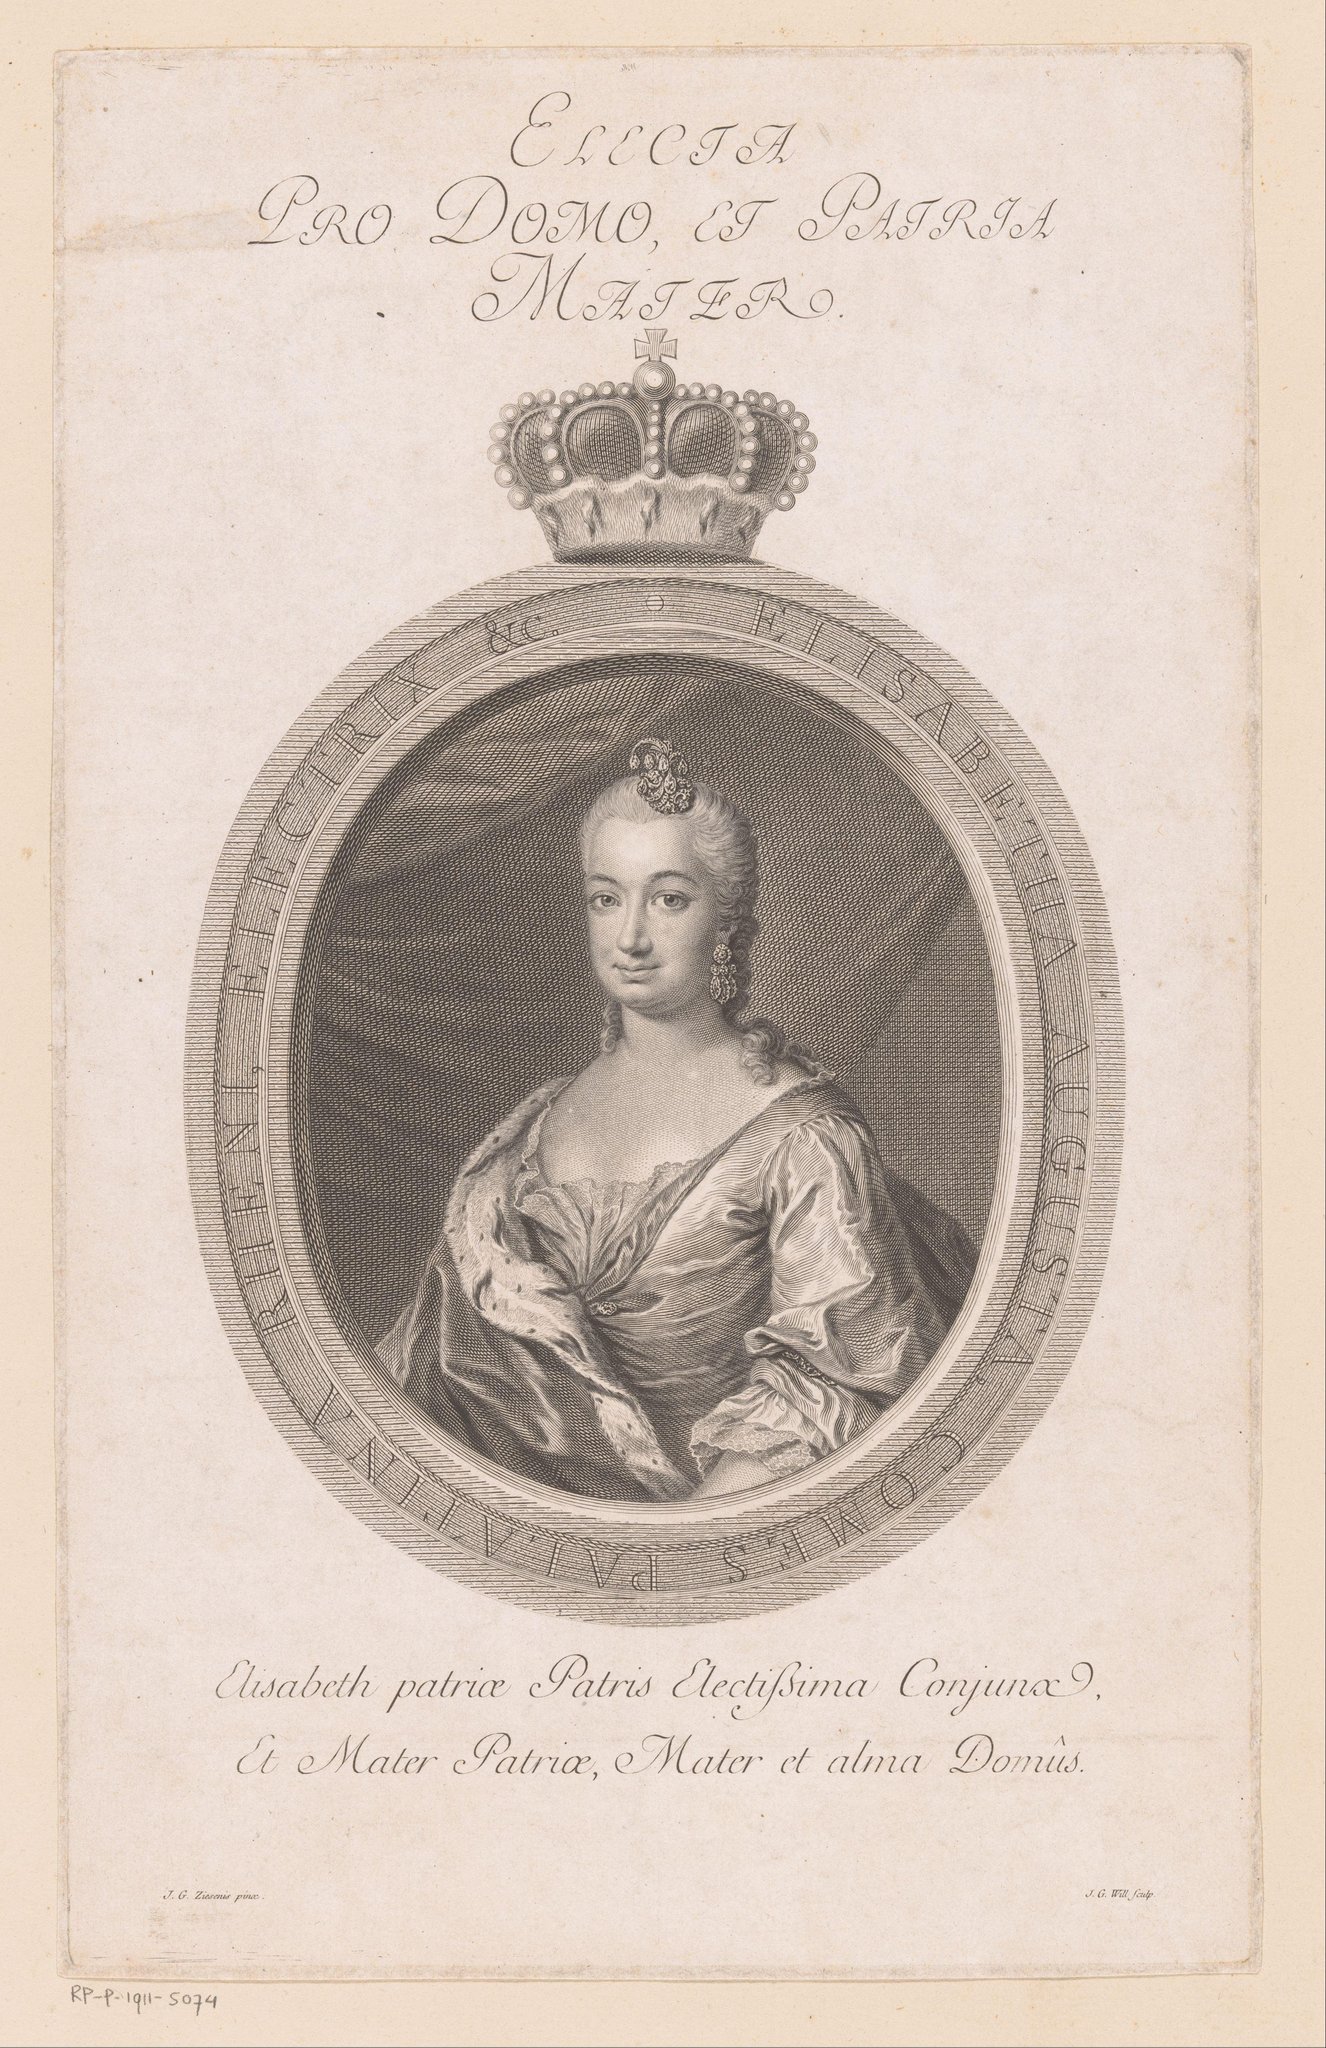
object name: print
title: Portret van Elisabeth Auguste von Pfalz-Sulzbach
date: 1748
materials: paper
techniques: engraving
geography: germany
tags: elisabeth auguste von pfalz-sulzbach, historical persons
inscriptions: collector's mark: Lugt 2228